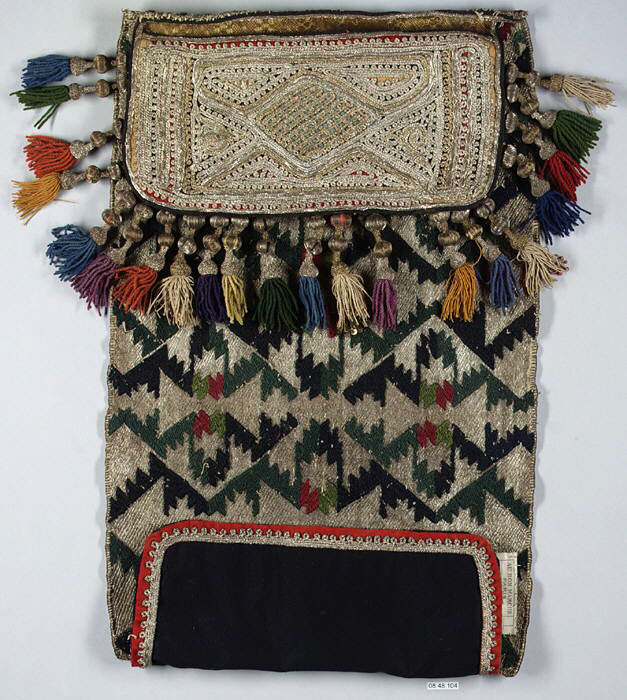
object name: apron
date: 1801-1900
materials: metal thread, wool